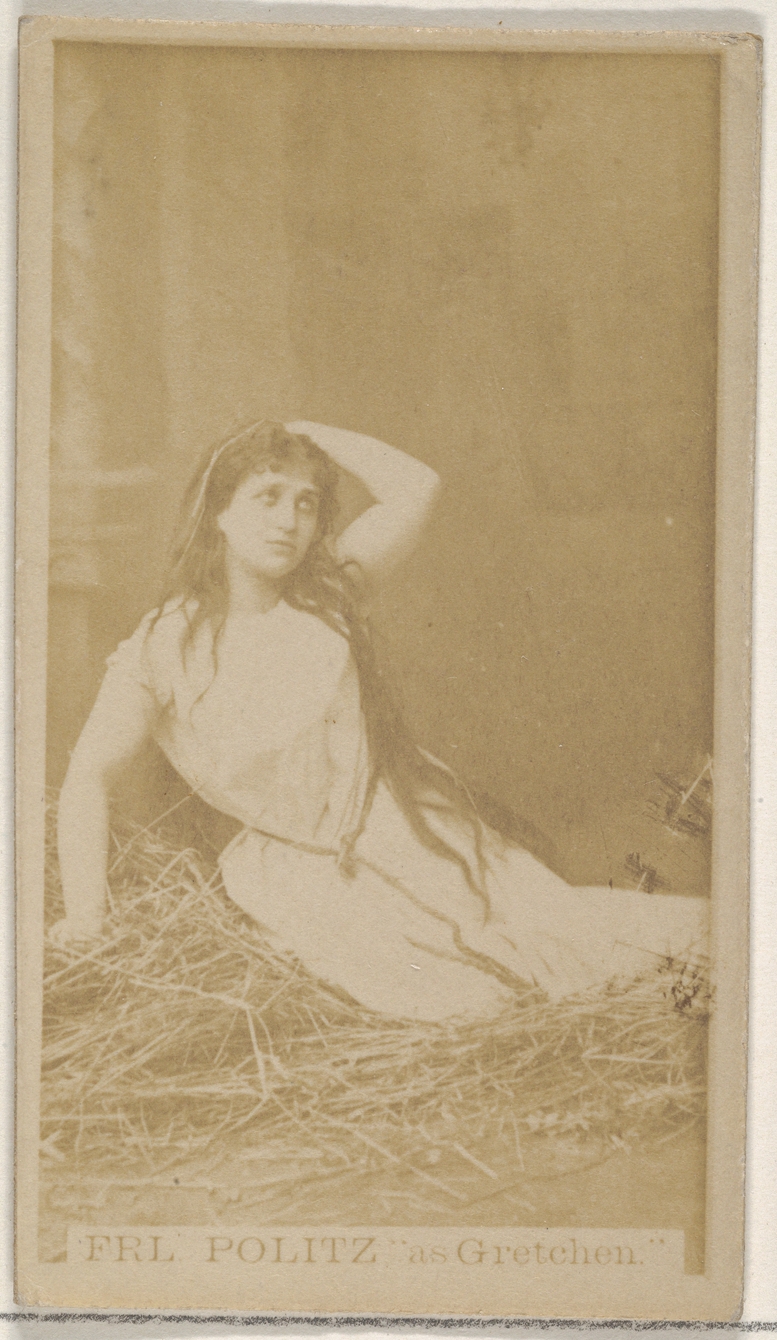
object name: photograph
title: Fräulein Politz as Gretchen, from the Actors and Actresses series (N45, Type 8) for Virginia Brights Cigarettes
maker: allen & ginter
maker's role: publisher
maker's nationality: american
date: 1888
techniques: albumen silver print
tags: portraits,women,actresses